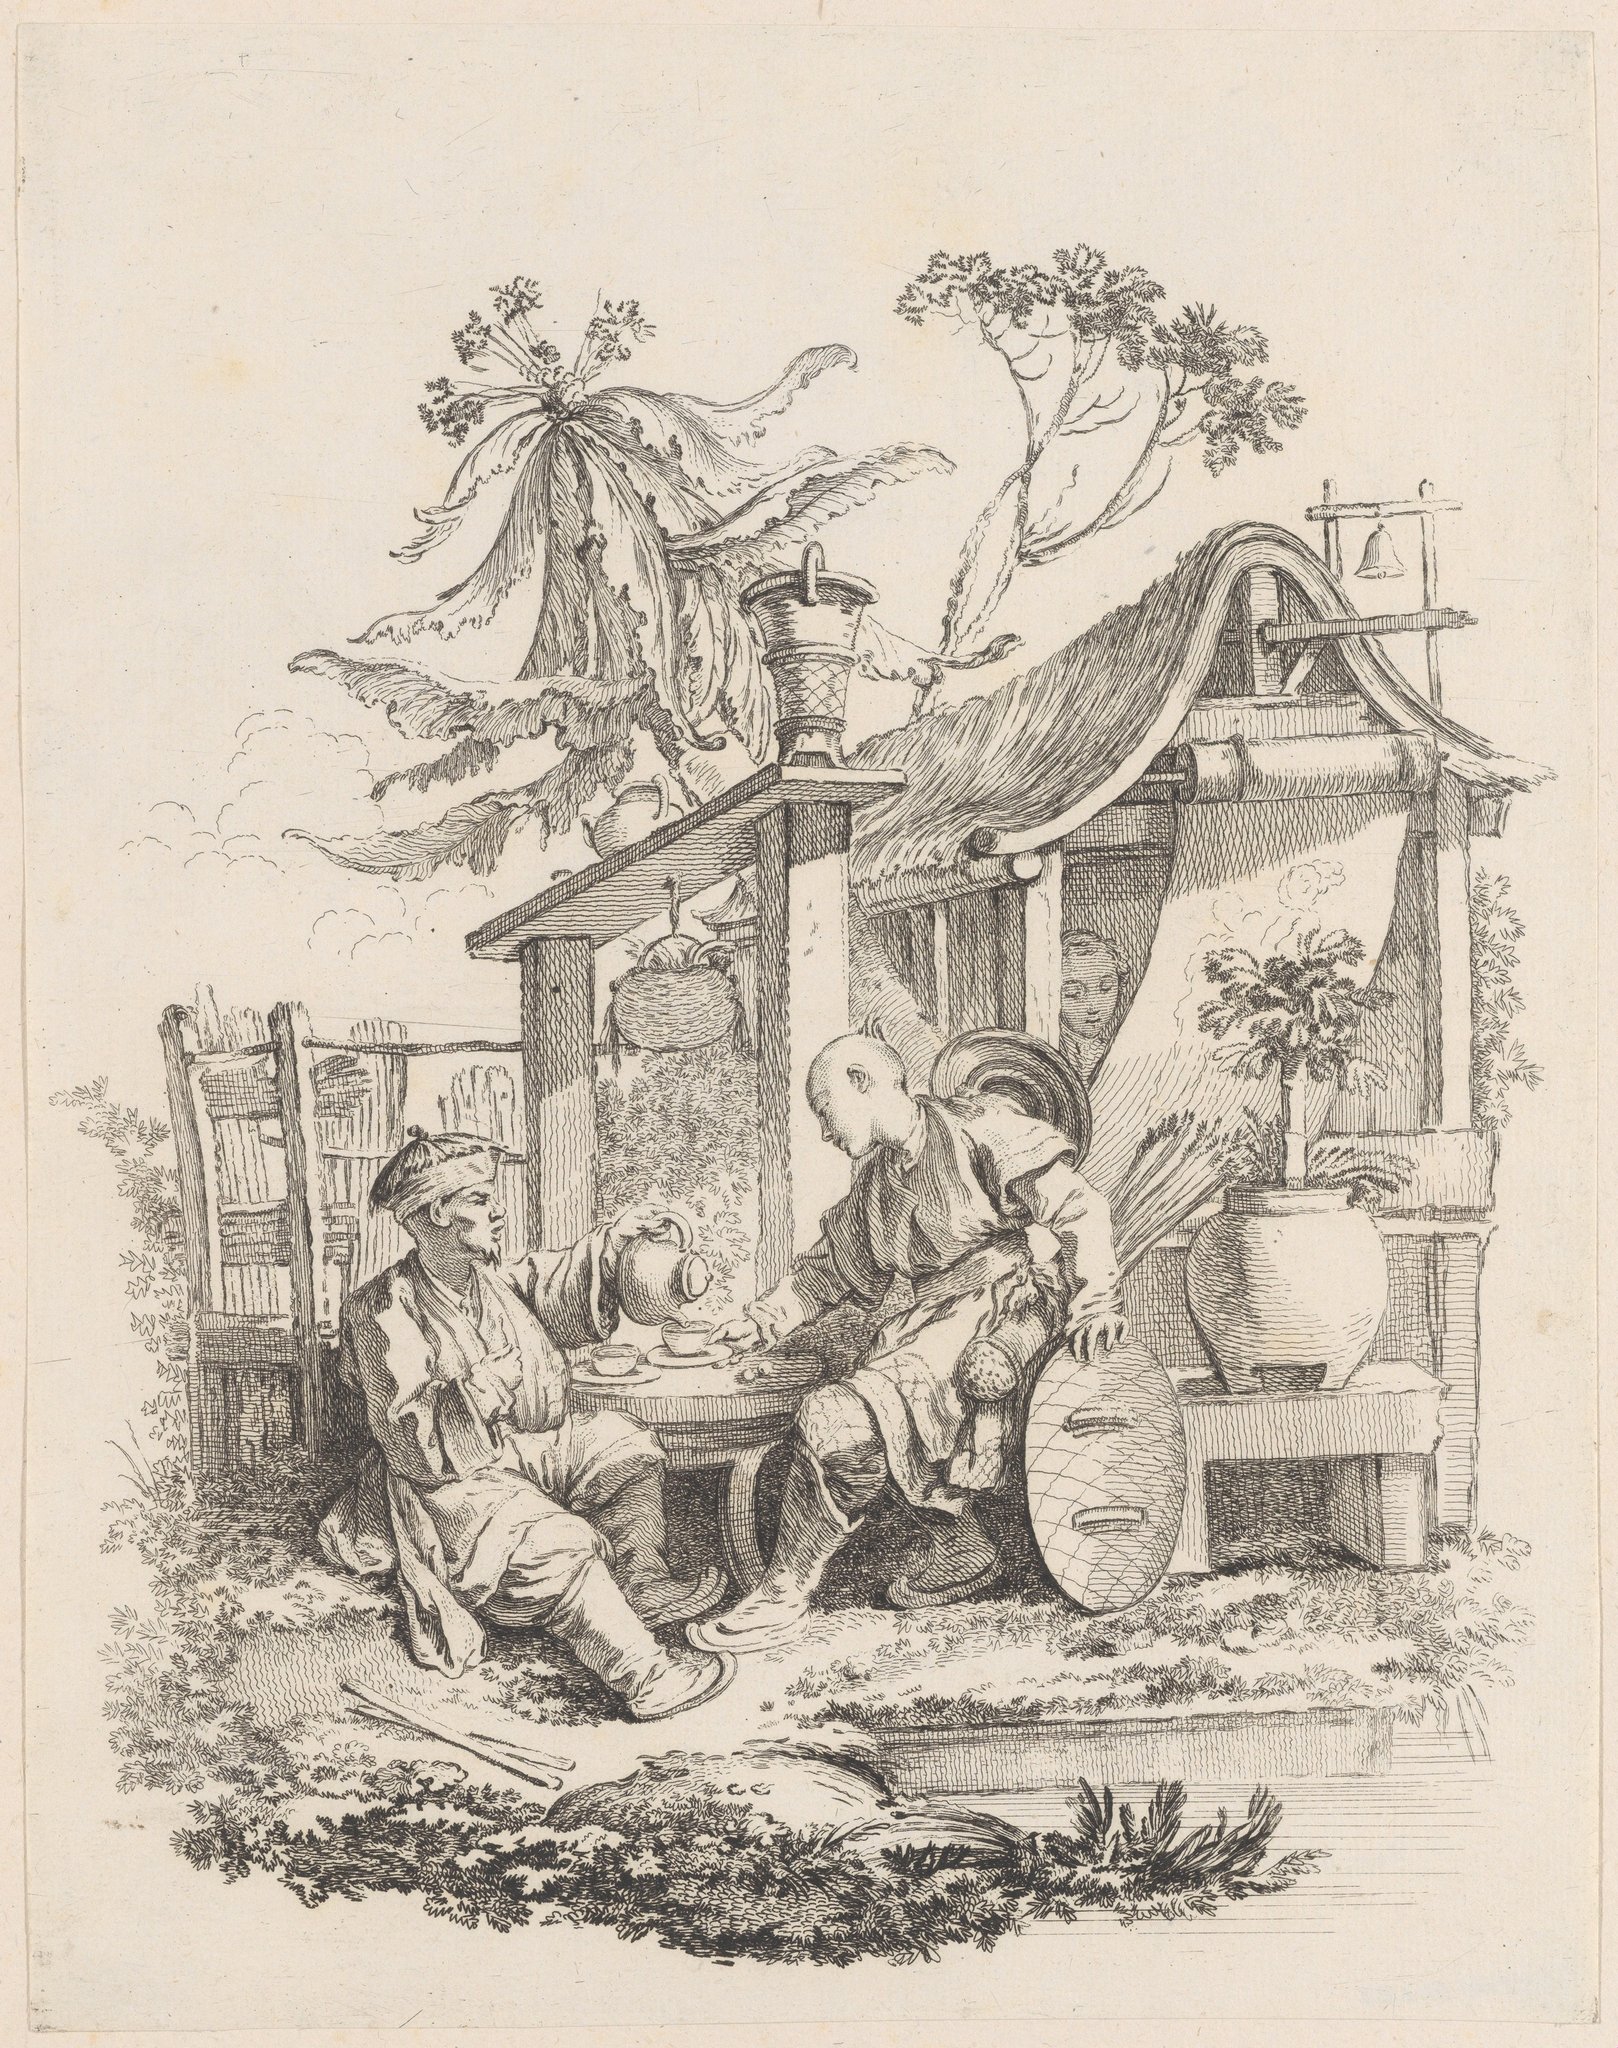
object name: print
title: Tea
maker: gabriel huquier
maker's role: artist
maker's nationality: french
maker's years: 1695-1772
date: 1738-1745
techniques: engraving, etching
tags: men,tea drinking